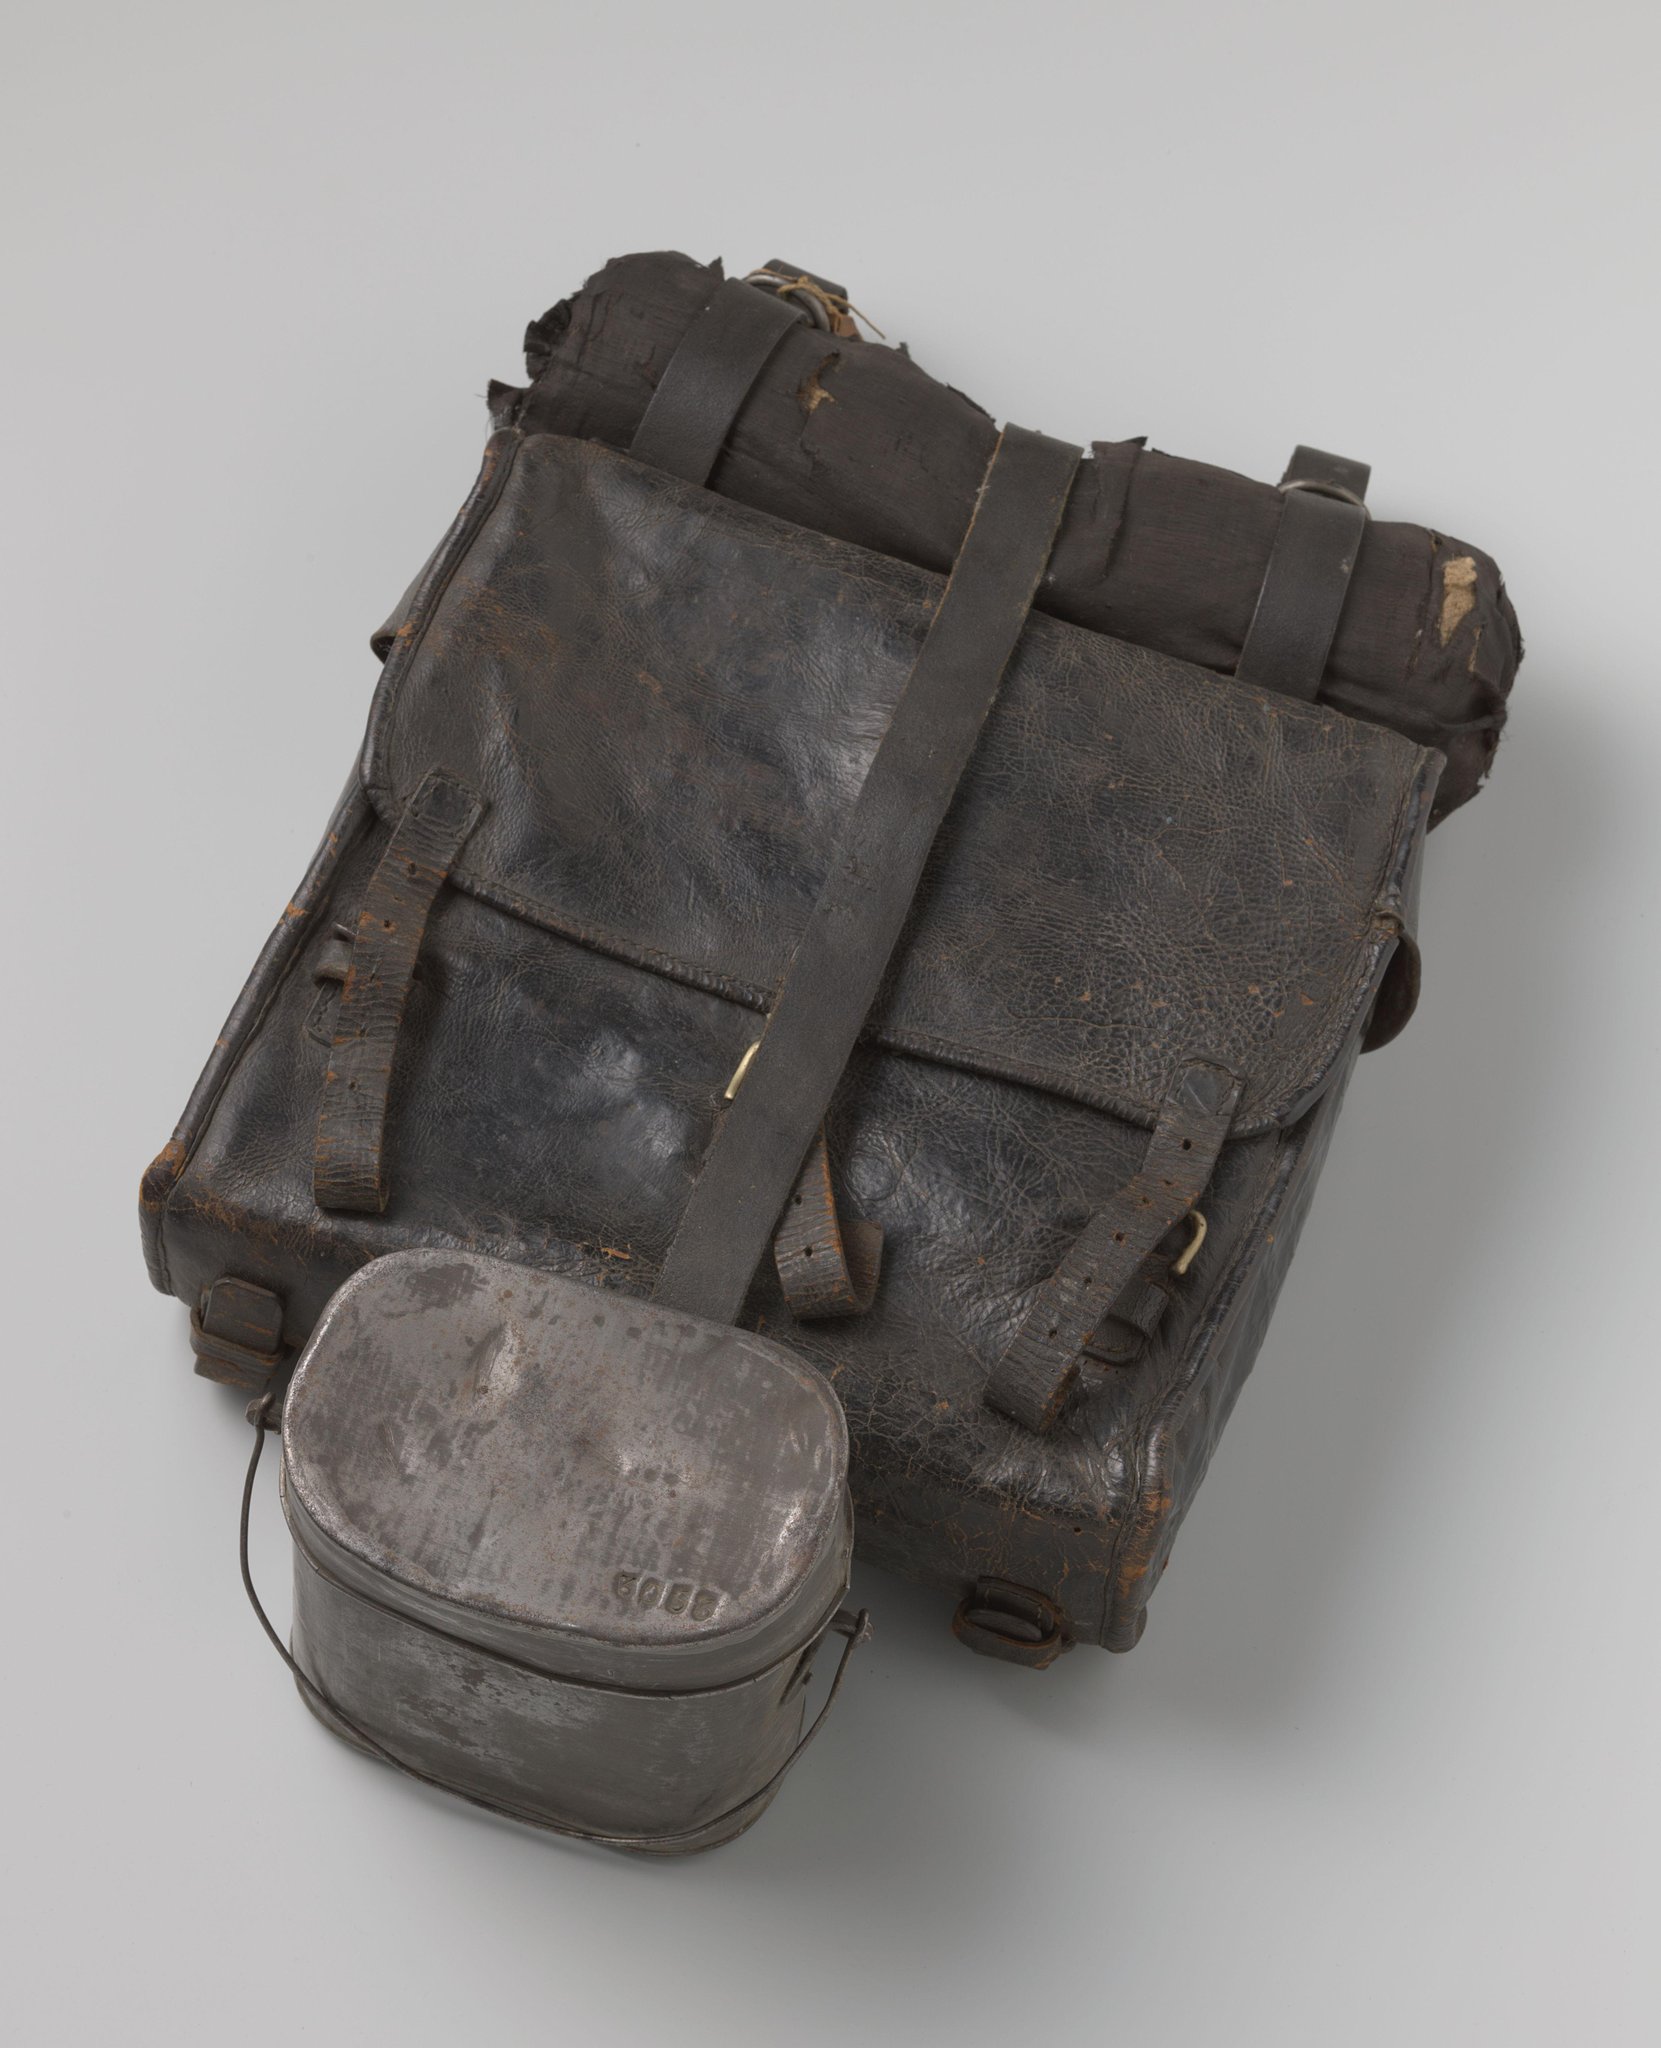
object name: kettle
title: Ransel gedragen door D.W. van Meeteren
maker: Anonymous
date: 1800-1830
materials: leather, metal, wool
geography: netherlands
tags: netherlands, belgium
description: Ransel met rolzak en (eet)ketel van zwart leer met zwart leren riemen. Gedragen door D.W. van Meeteren, in 1830/32 Vrijwillig Jager bij het korps Jagers van Rookmaker.